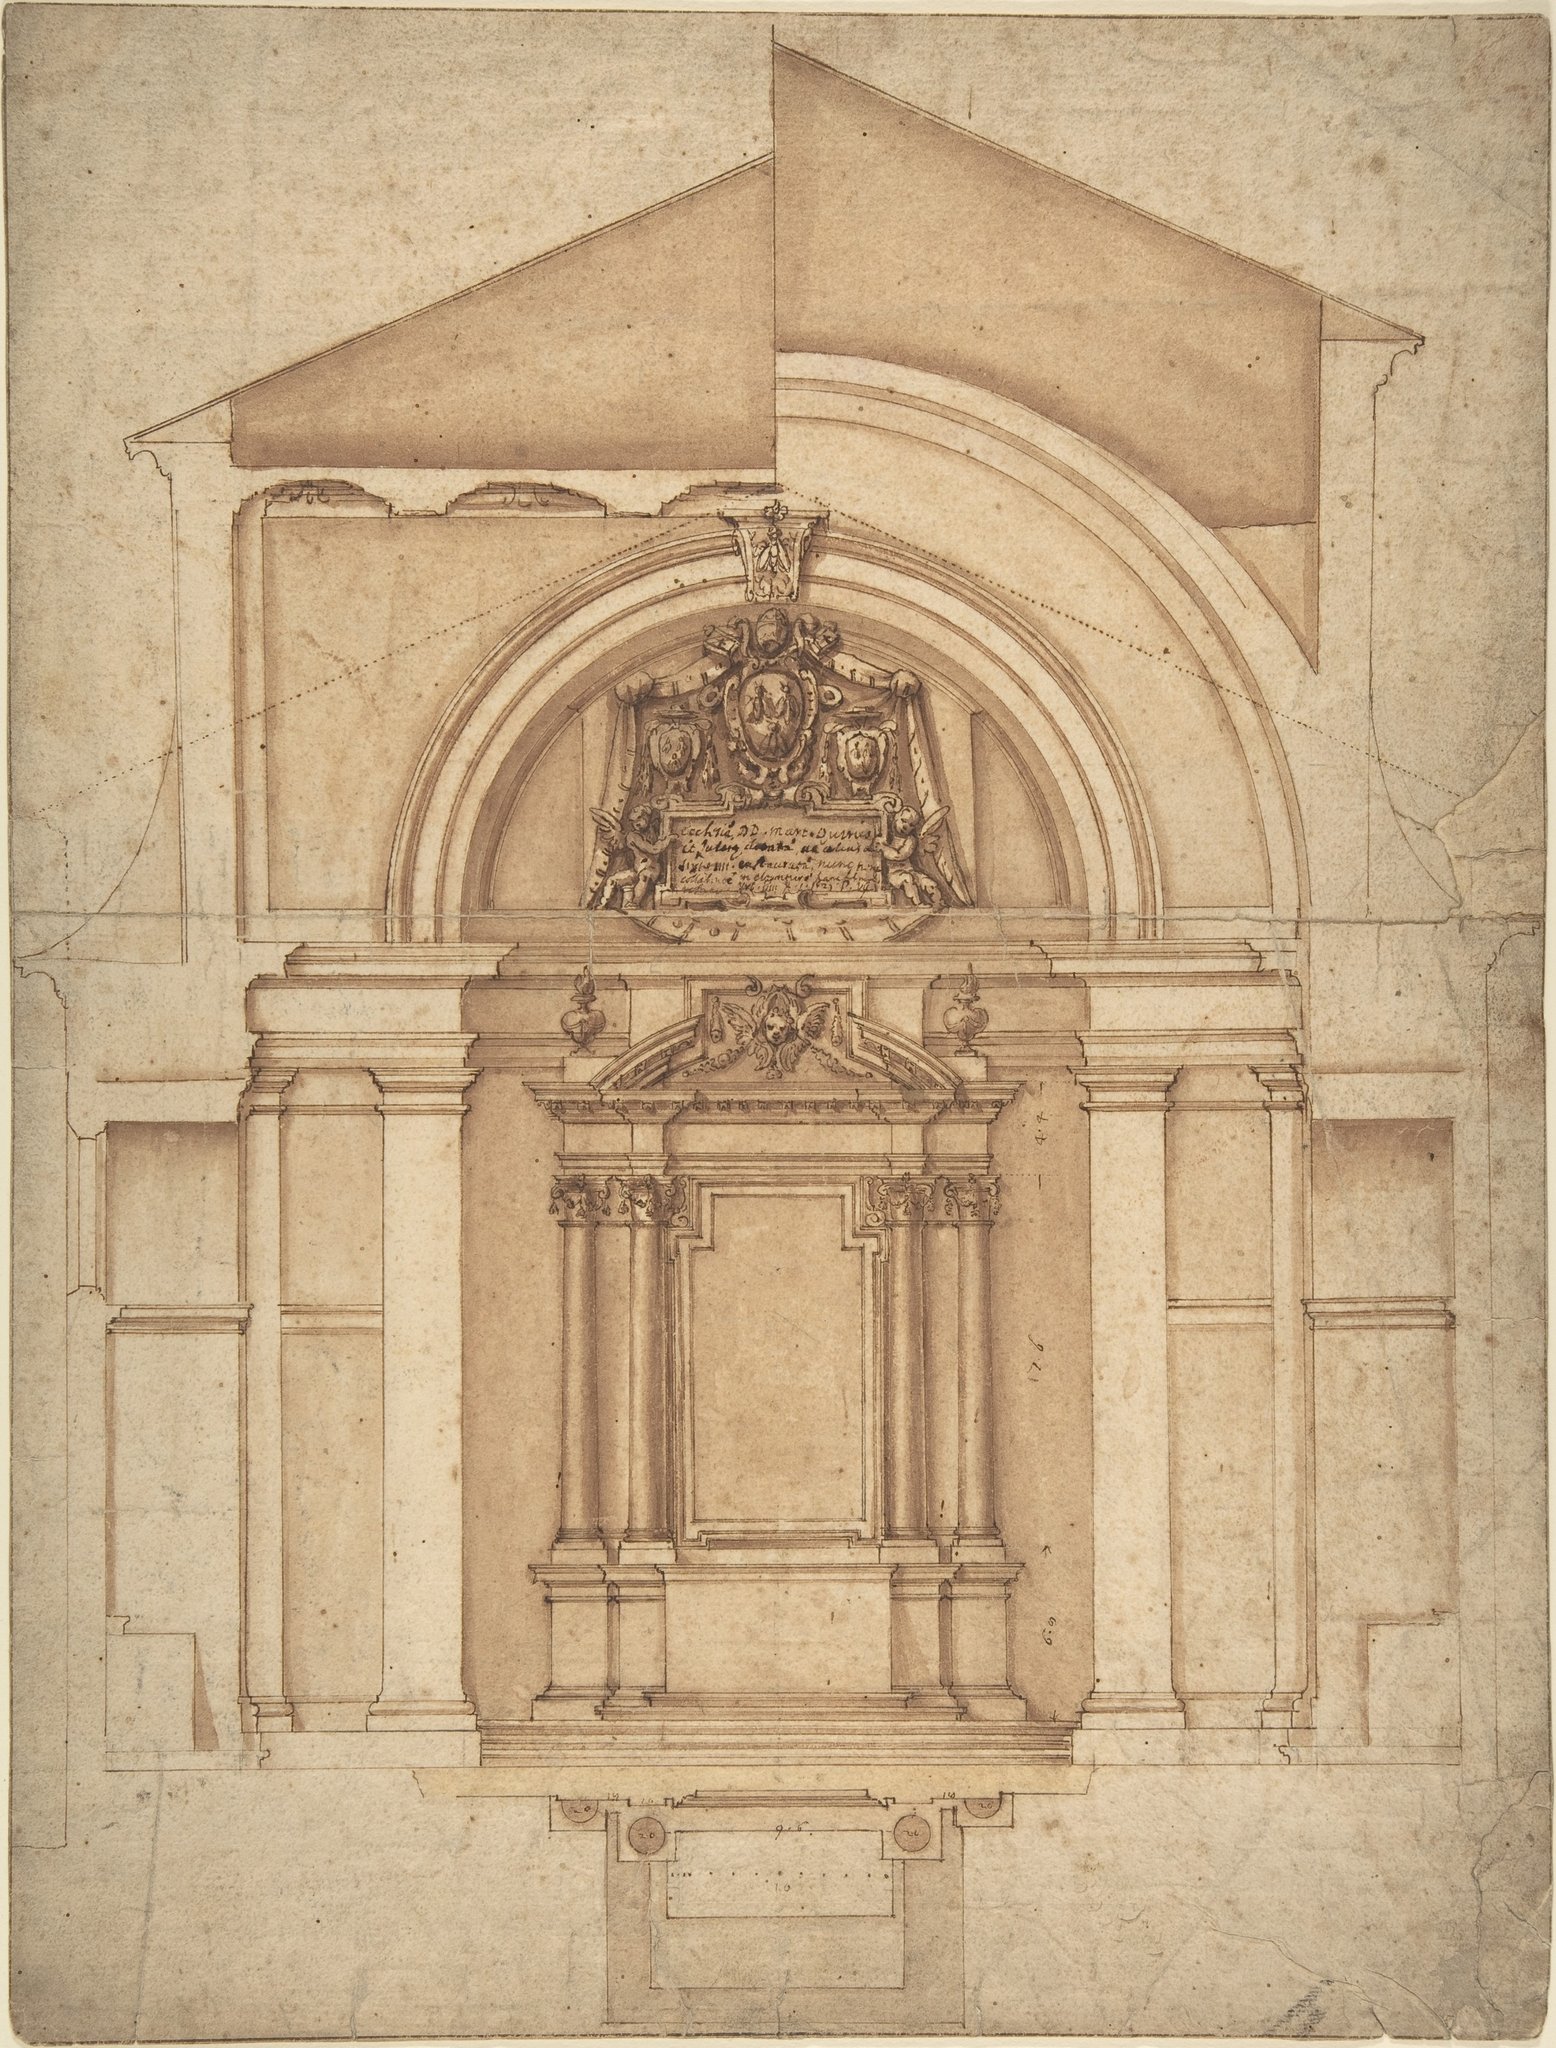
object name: drawing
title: Project for an Altar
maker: anonymous, italian, 17th century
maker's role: artist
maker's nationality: italian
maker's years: 1600-1700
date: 1601-1700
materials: graphite, ink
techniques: brush, pen, drawing, wash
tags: altars